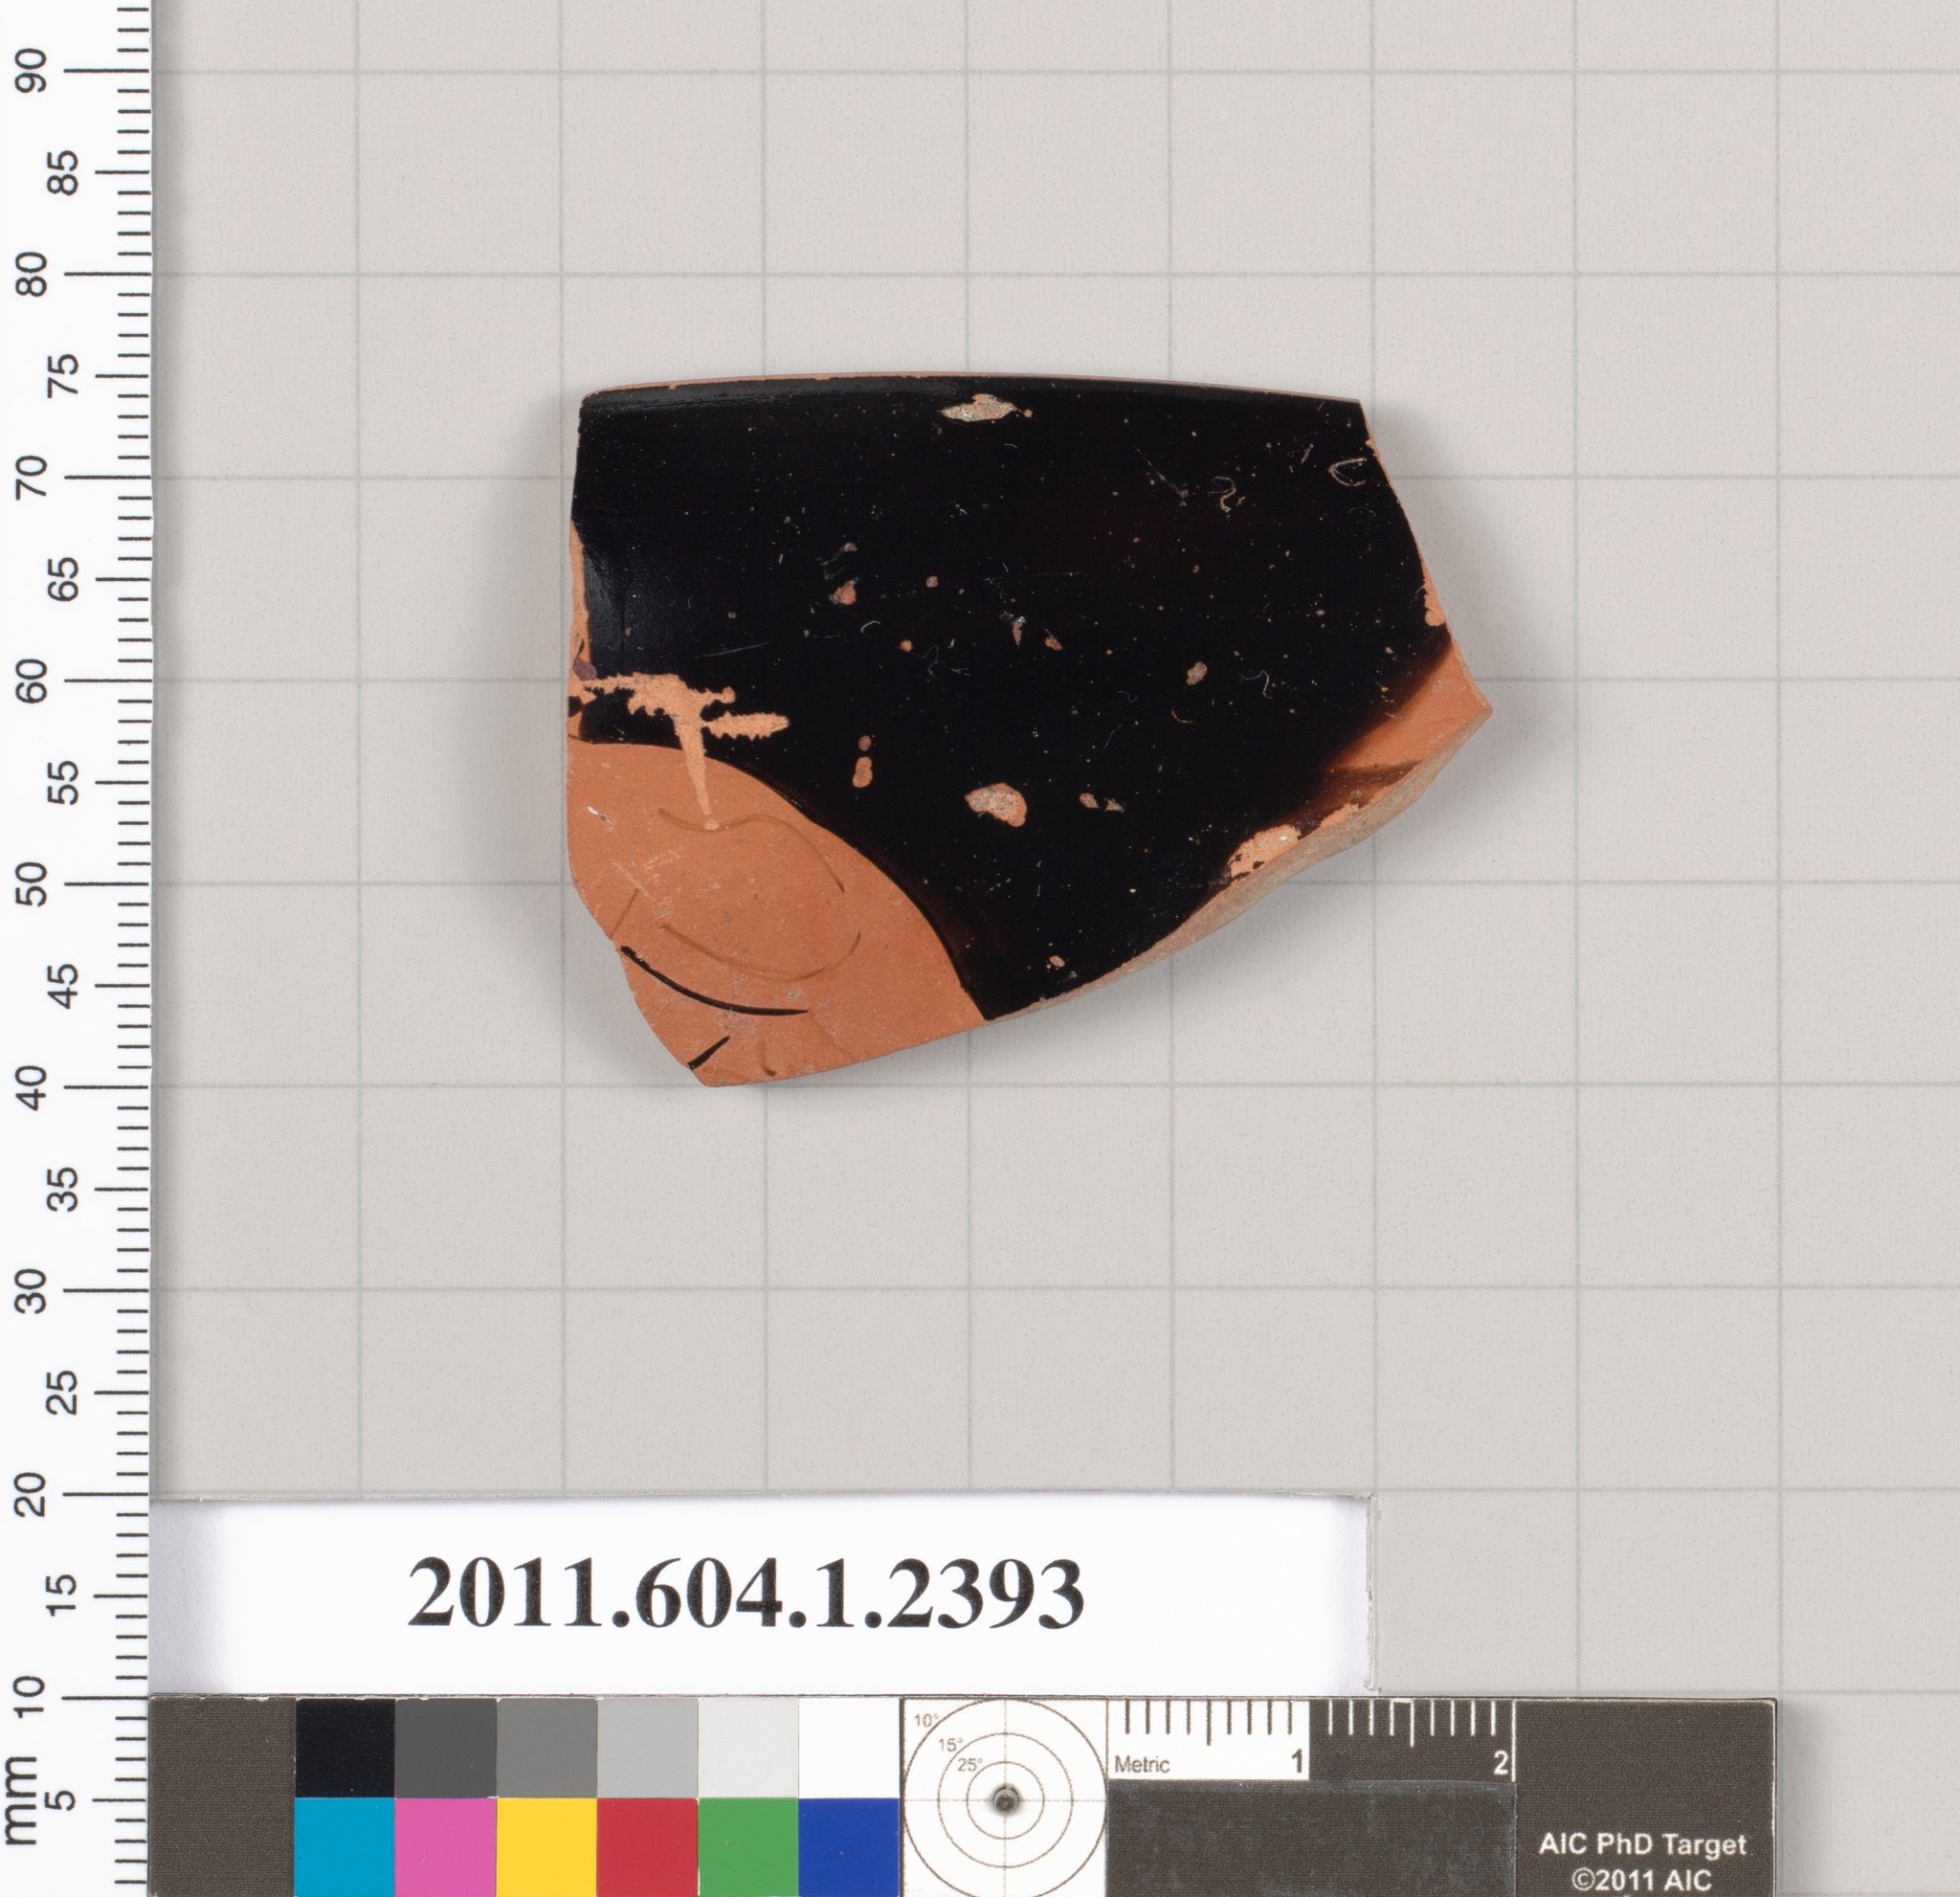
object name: kylix fragment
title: Terracotta rim fragment of a kylix (drinking cup)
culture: greek, attic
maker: brygos painter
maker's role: artist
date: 490-480 BCE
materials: terracotta